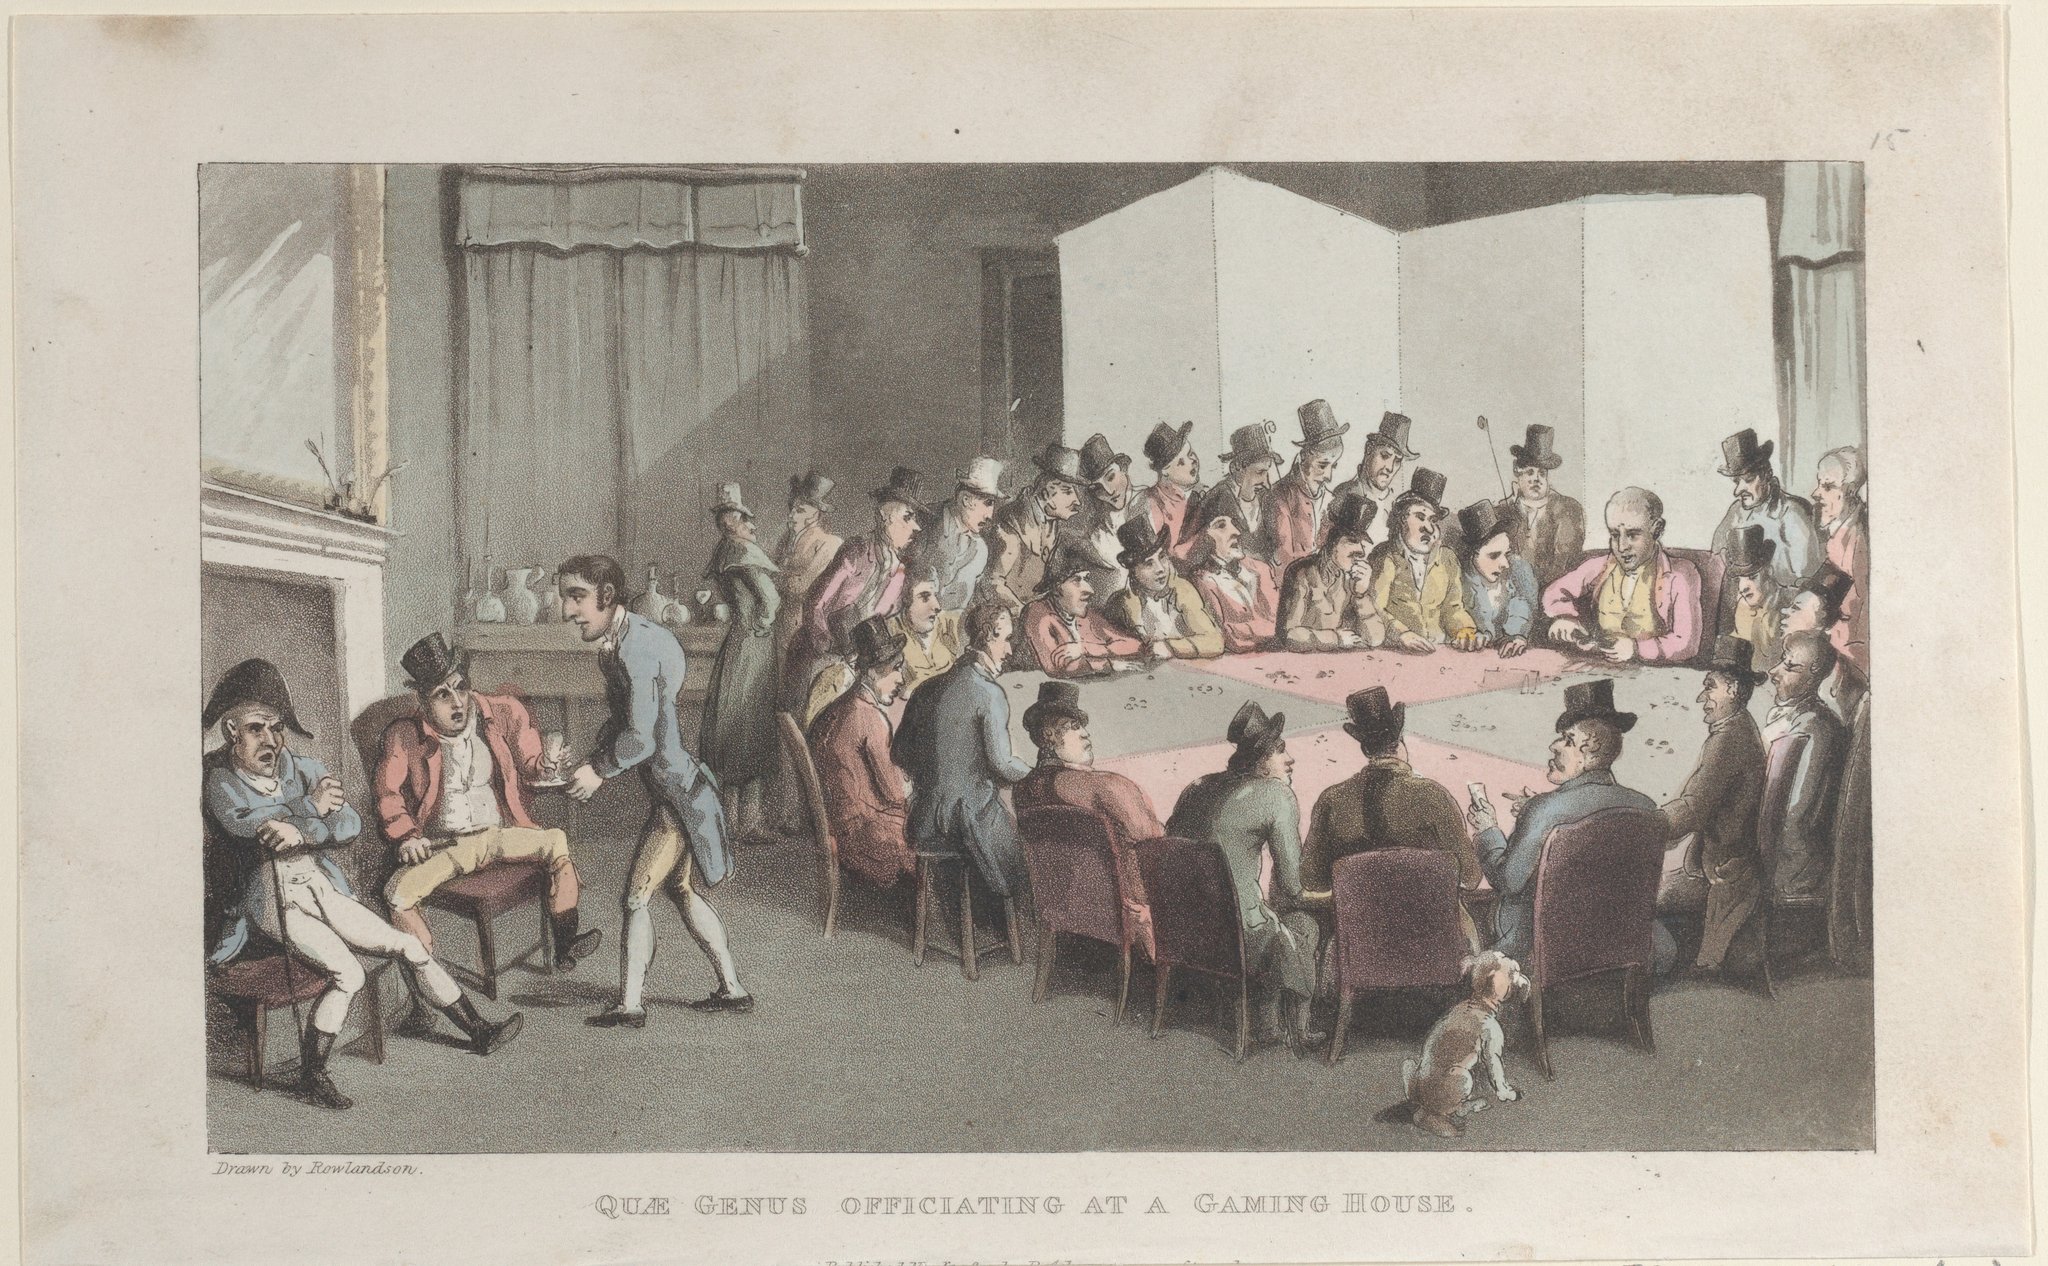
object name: print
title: Quae Genus Officiating at a Gaming House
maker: thomas rowlandson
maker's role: artist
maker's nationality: british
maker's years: 1757-1827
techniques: aquatint, etching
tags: satire,men,gambling,dogs